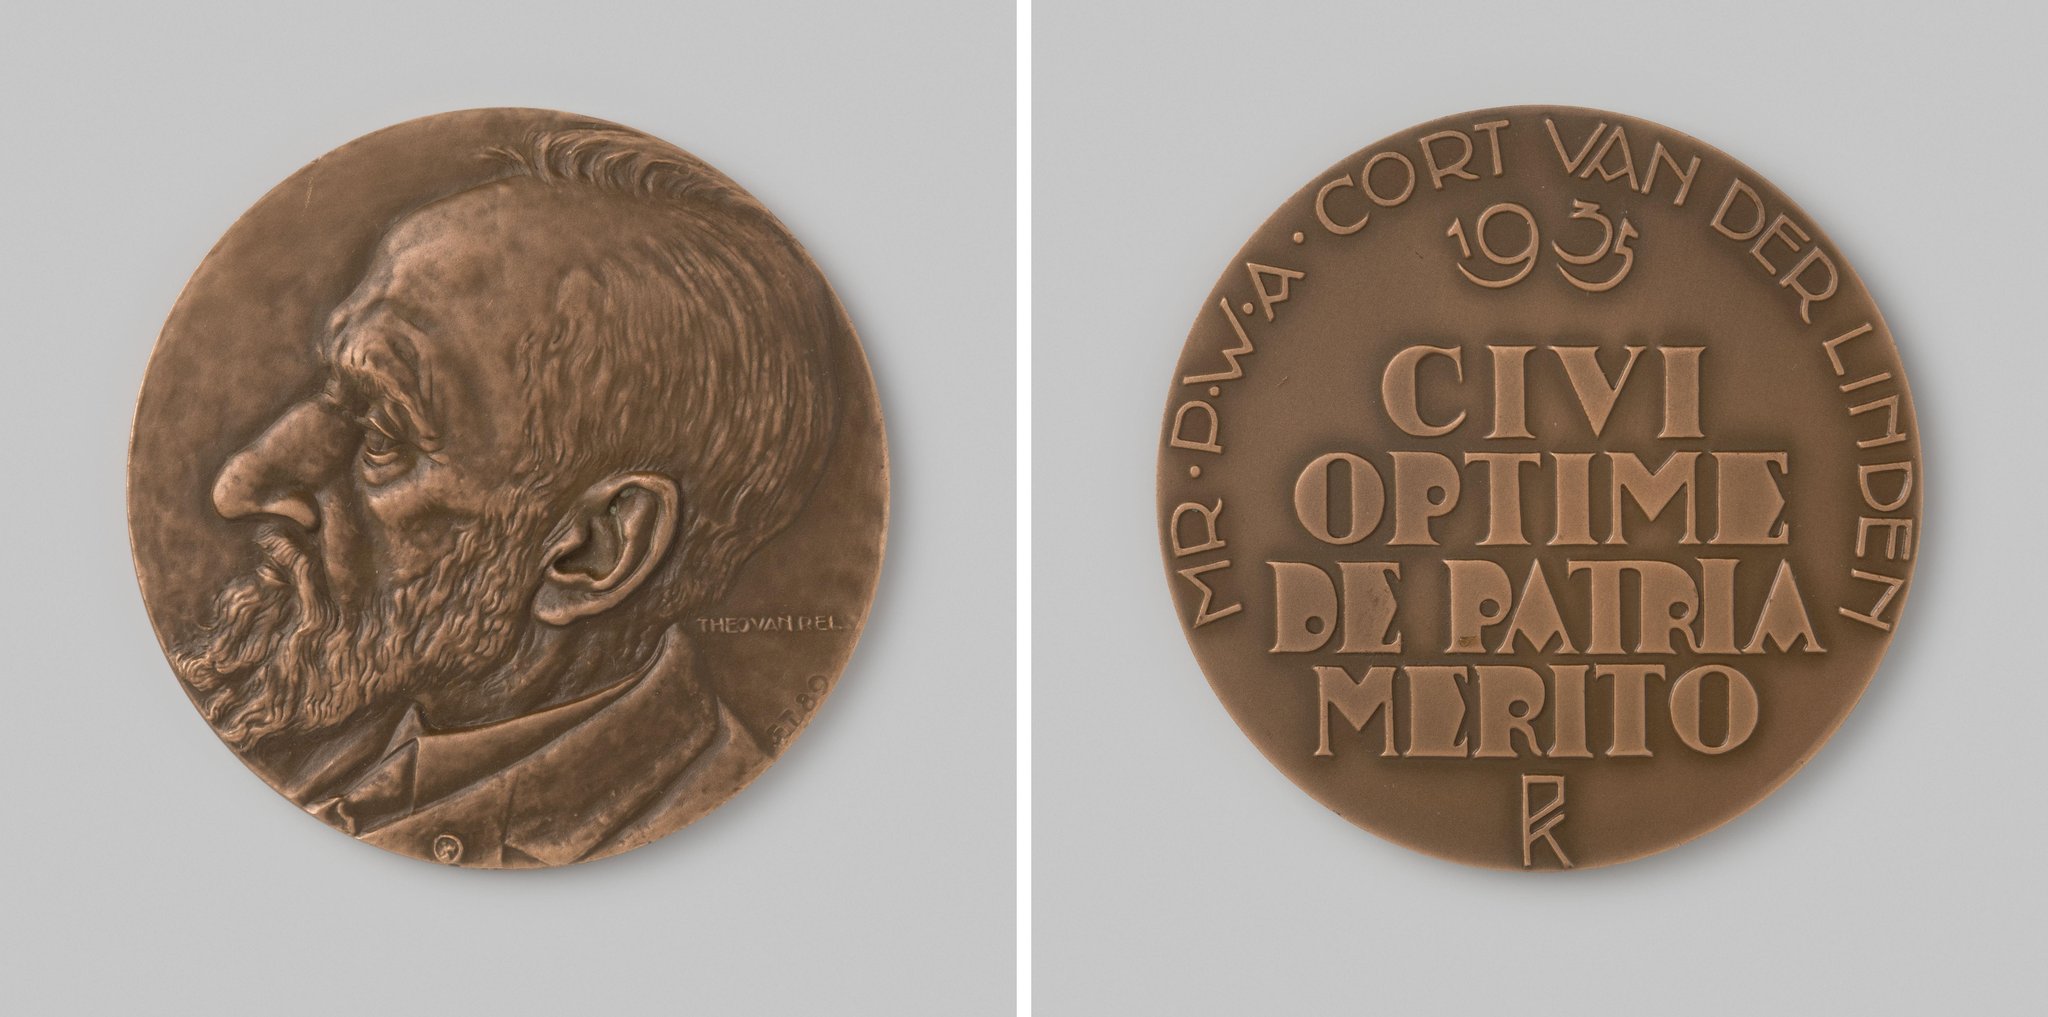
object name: medal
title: Meester P.W.A. Cort van der Linden (Vereniging voor Penningkunst 1935, eerste penning)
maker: theo van reijn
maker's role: draughtsman, print maker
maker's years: 1884-1954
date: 1935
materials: bronze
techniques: striking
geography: voorschoten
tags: pieter wilhelm adriaan cort van der linden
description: Mr. P.W.A. Cort van der Linden (1846-1935) werd in 1913 Minister-President van een extra-parlementair kabinet bestaande uit liberalen en partijlozen en bleef dat gedurende de gehele Eerste Wereldoorlog. Tijdens zijn regering werd het algemeen kiesrecht ingevoerd. De bejaarde staatsman poseerde enige malen voor de Haarlemse beeldhouwer en overleed op 89-jarige leeftijd toen de penning net uitgegeven was. In art-déco-belettering is te lezen: 'Civi optime de patria merito'. Opgedragen aan de burger die zich buitengewoon verdienstelijk heeft gemaakt voor het vaderland. In deze portretopvatting ziet men de voorsprong van een niet-professionele penningmaker: een medailleur zou nooit dit gezichtspunt gekozen hebben; een naturalistische, scherp getekende oude kop met een magere hals schuin van boven gezien. Deze blikrichting geeft een indruk van nabijheid. Alle aandacht gaat naar de karakteristieken van de kop zelf, alleen een rozetje op de revers herinnert aan maatschappelijke verdiensten. Het is een peinzende kop die de cirkel vult, liefdevol geobserveerd. Hij is op grotere schaal ontworpen en de reductiebank heeft door de concentratie, die de verkleining met zich mee kan brengen, de werking versterkt. Hij is heel dun geslagen, met een beweeglijk fond, waarin men de beeldhouwer herkent die de belettering in mooie verscheidenheid met veel aandacht ontworpen heeft.